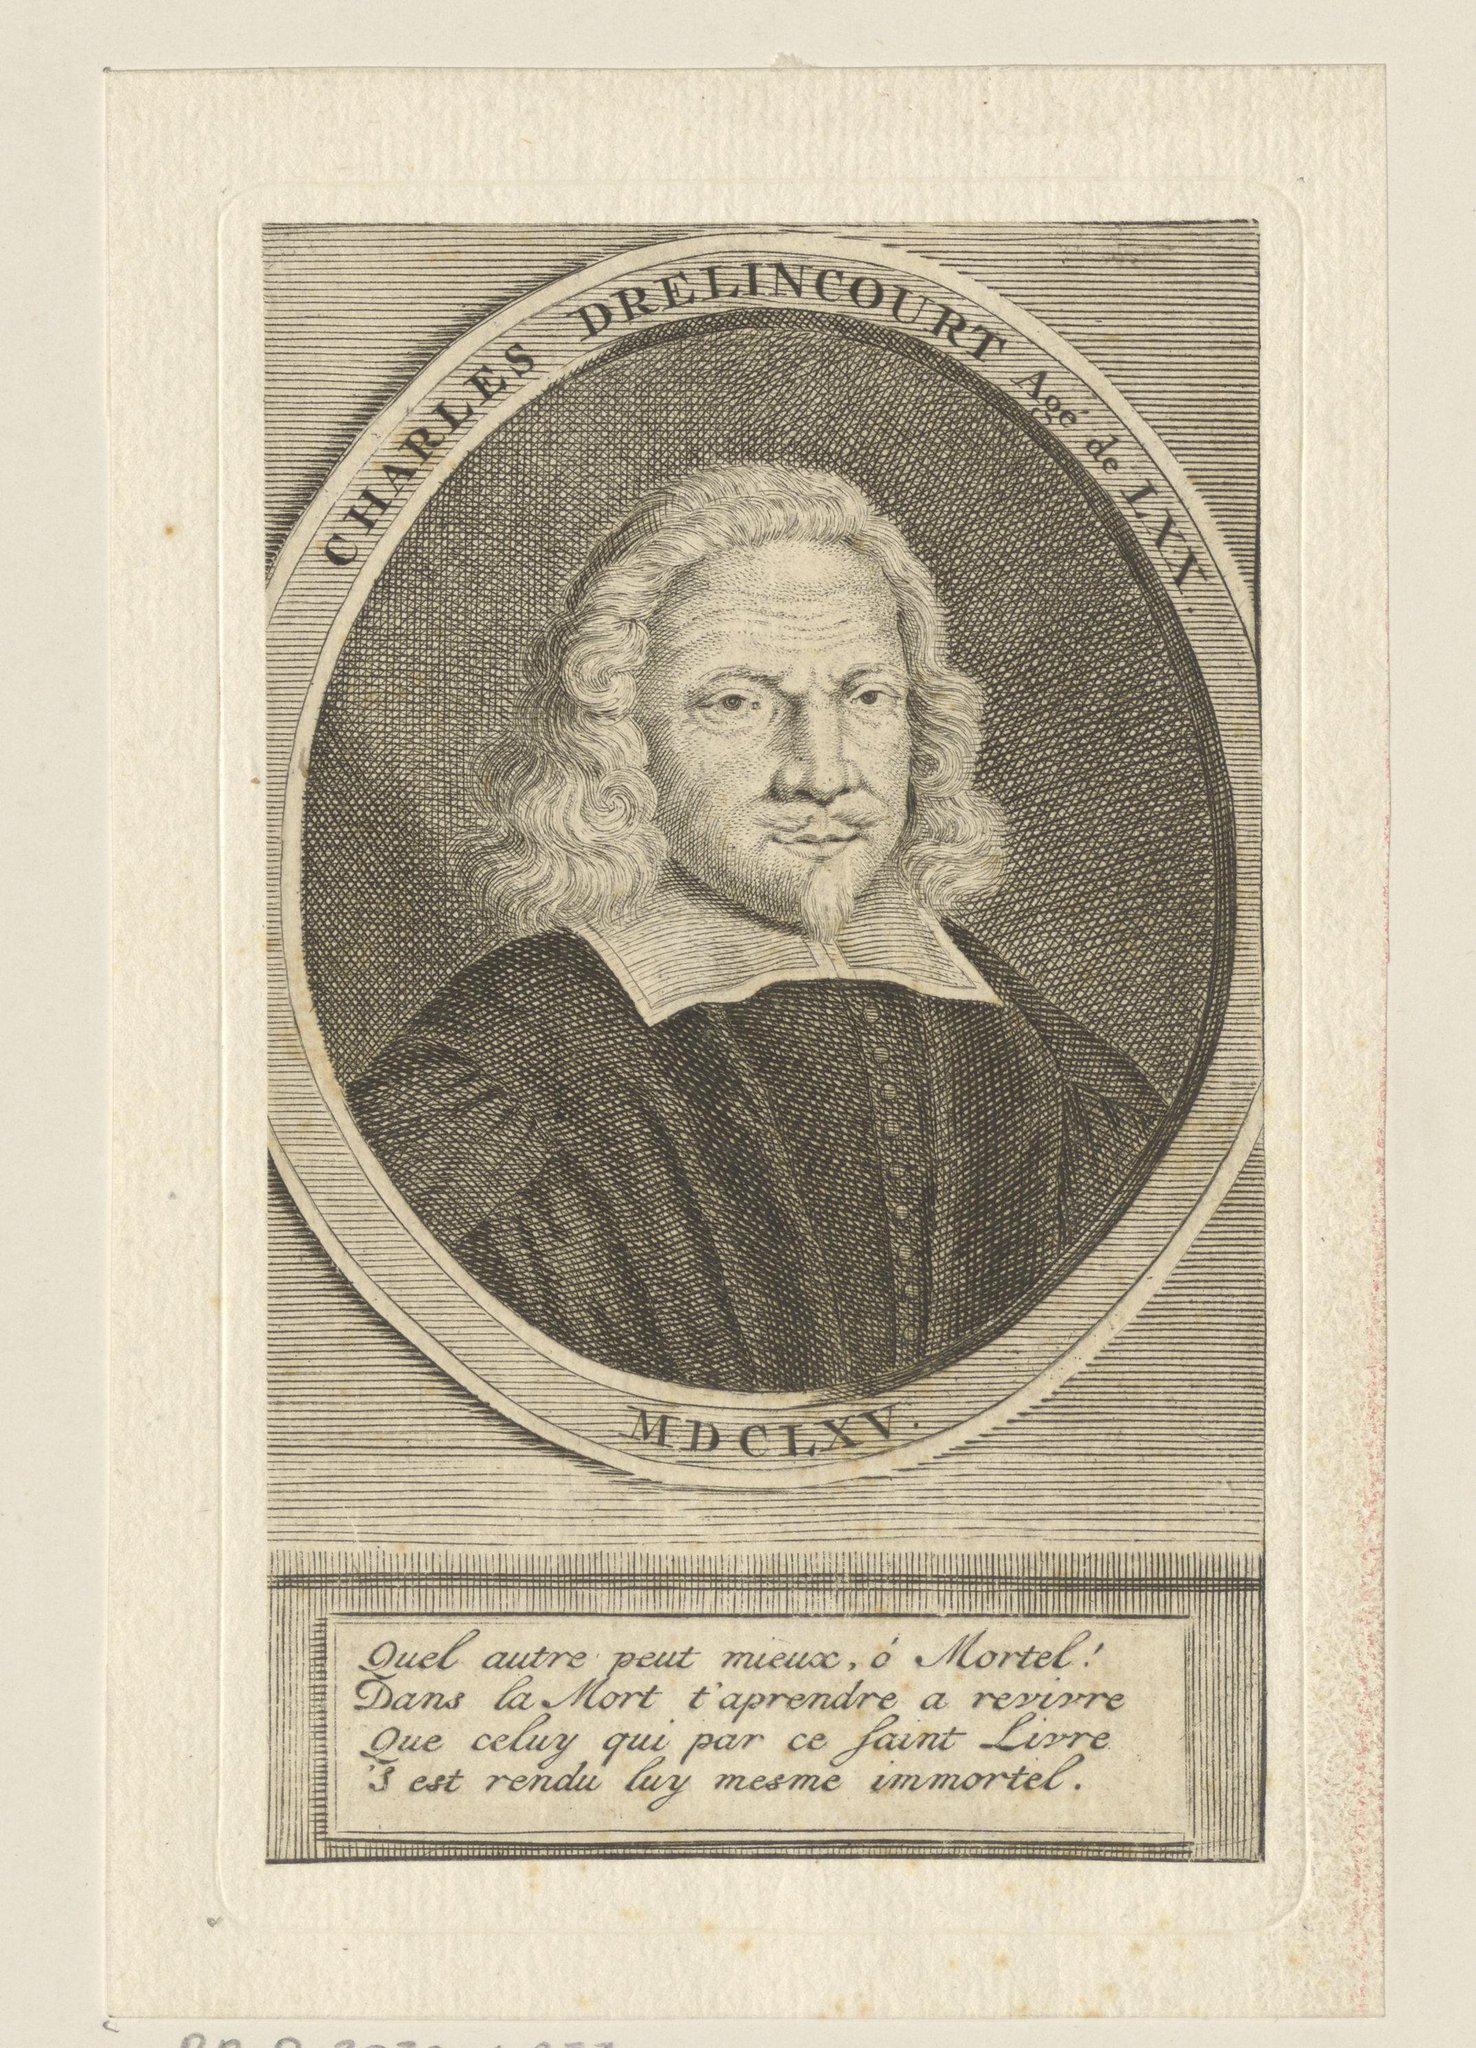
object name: print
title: Portret van Charles Drelincourt op 70-jarige leeftijd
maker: Anonymous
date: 1665-1780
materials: paper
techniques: engraving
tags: theologian, historical persons